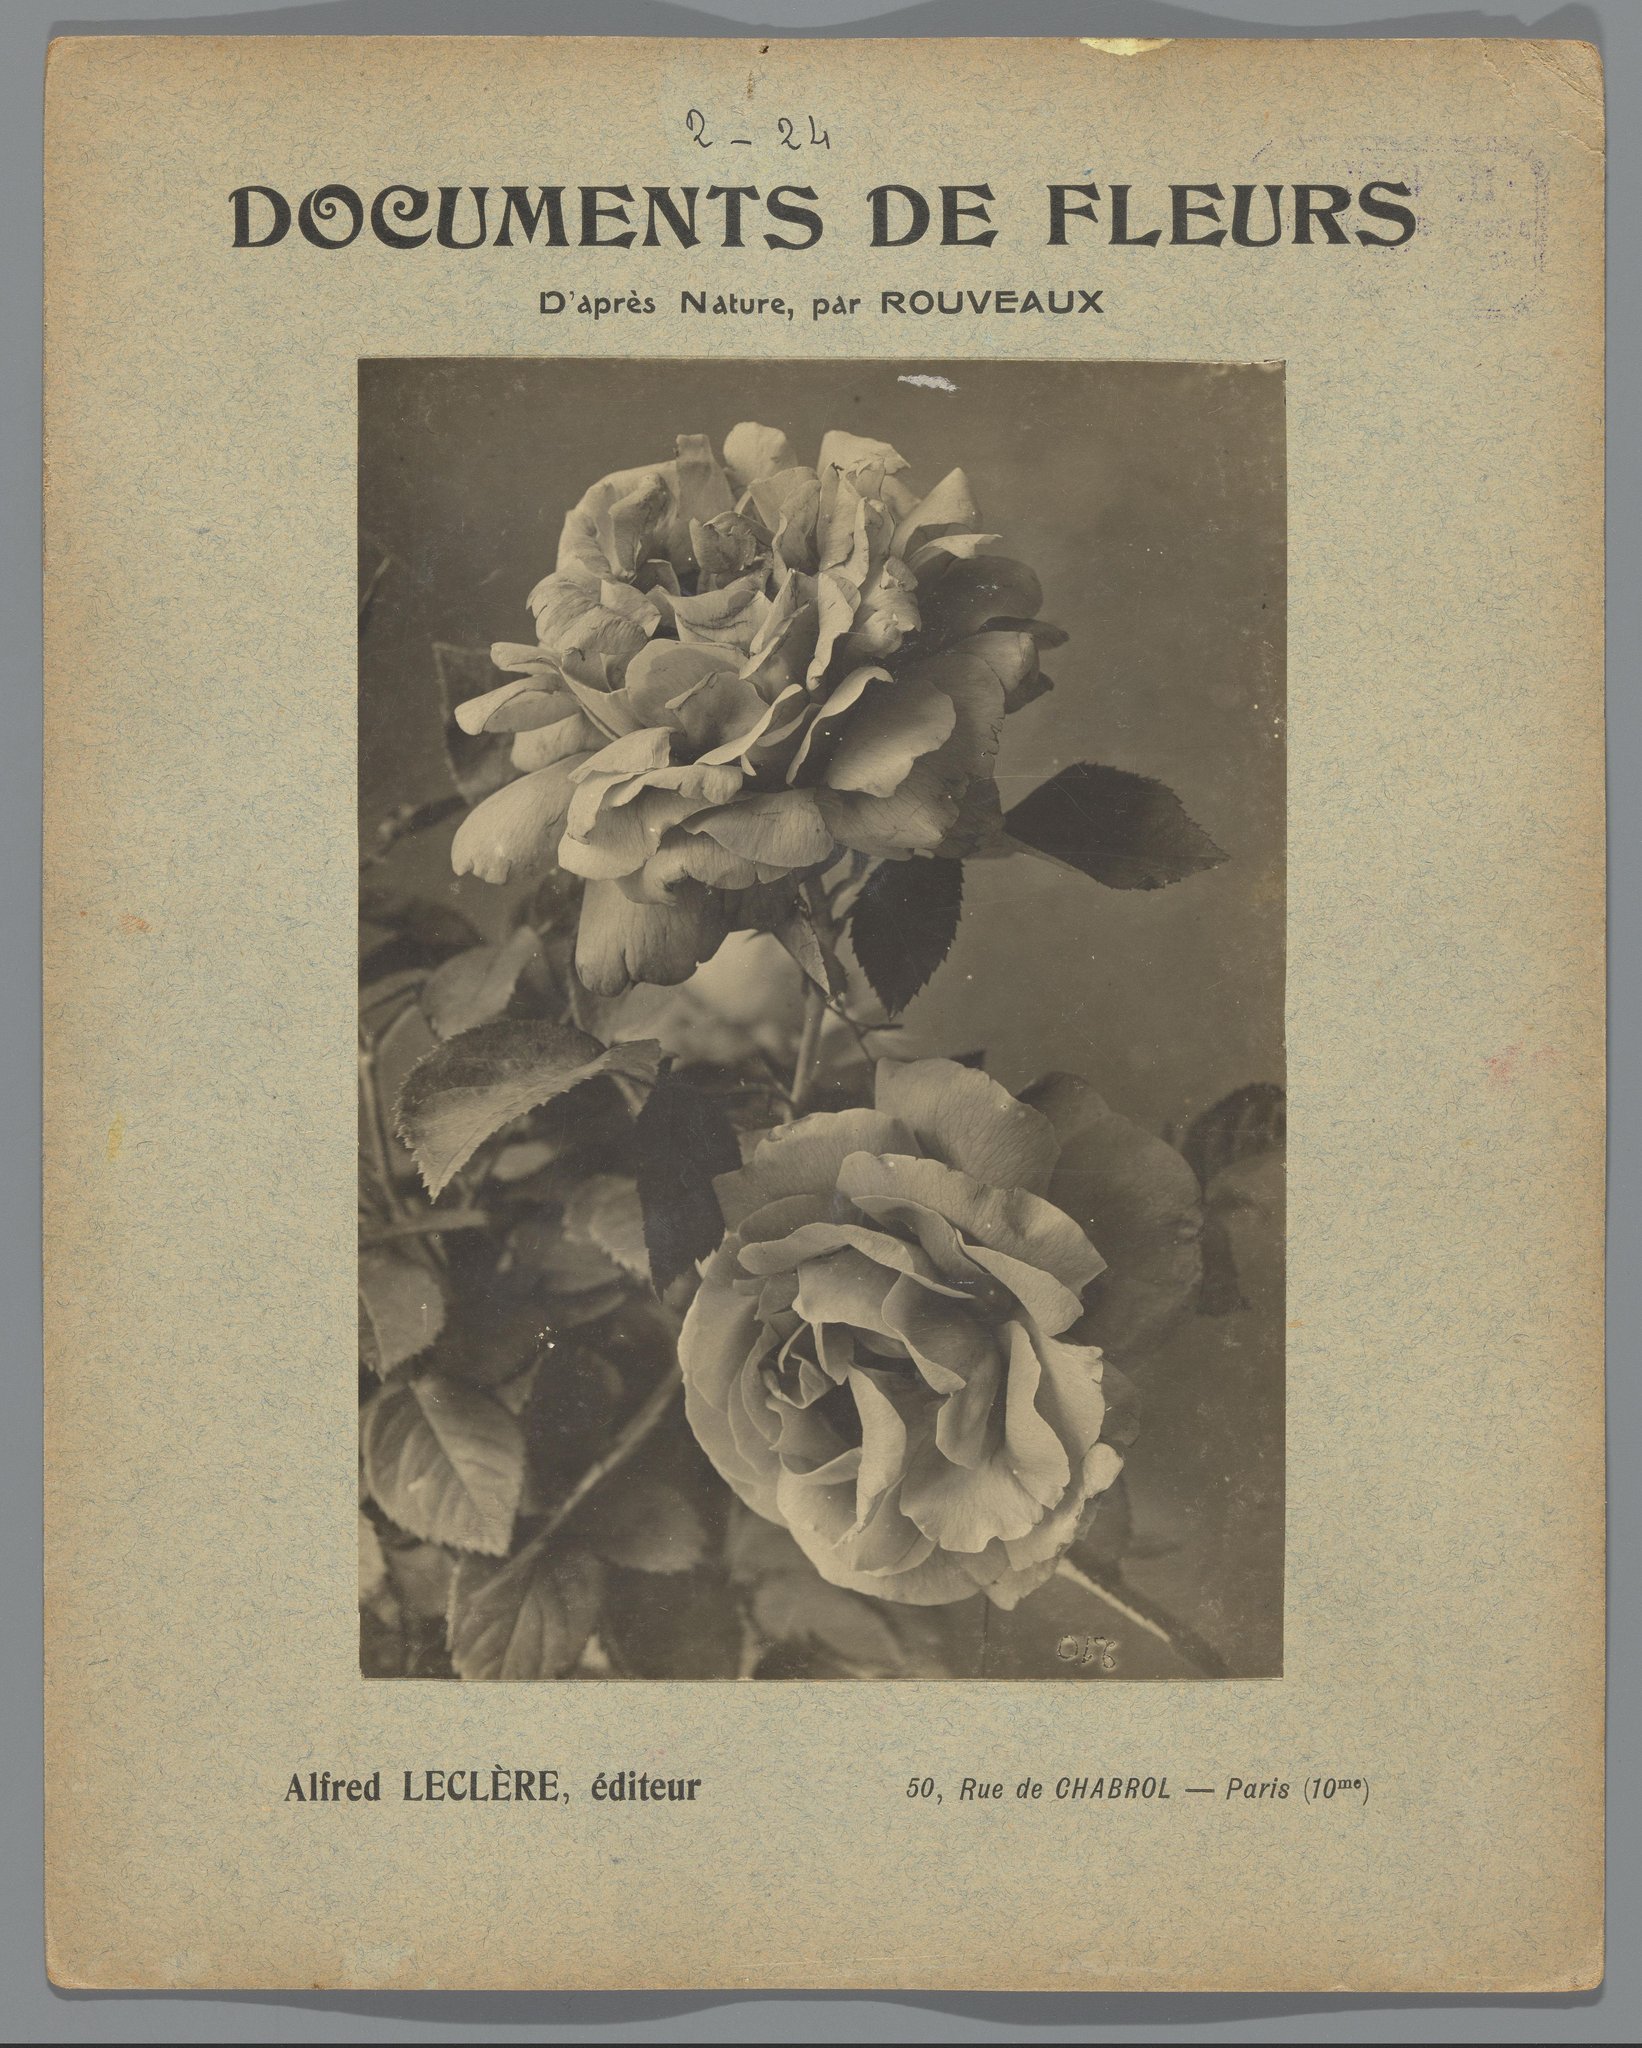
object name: photograph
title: Bloemstudie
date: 1895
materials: photographic support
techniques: gelatin silver print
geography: france